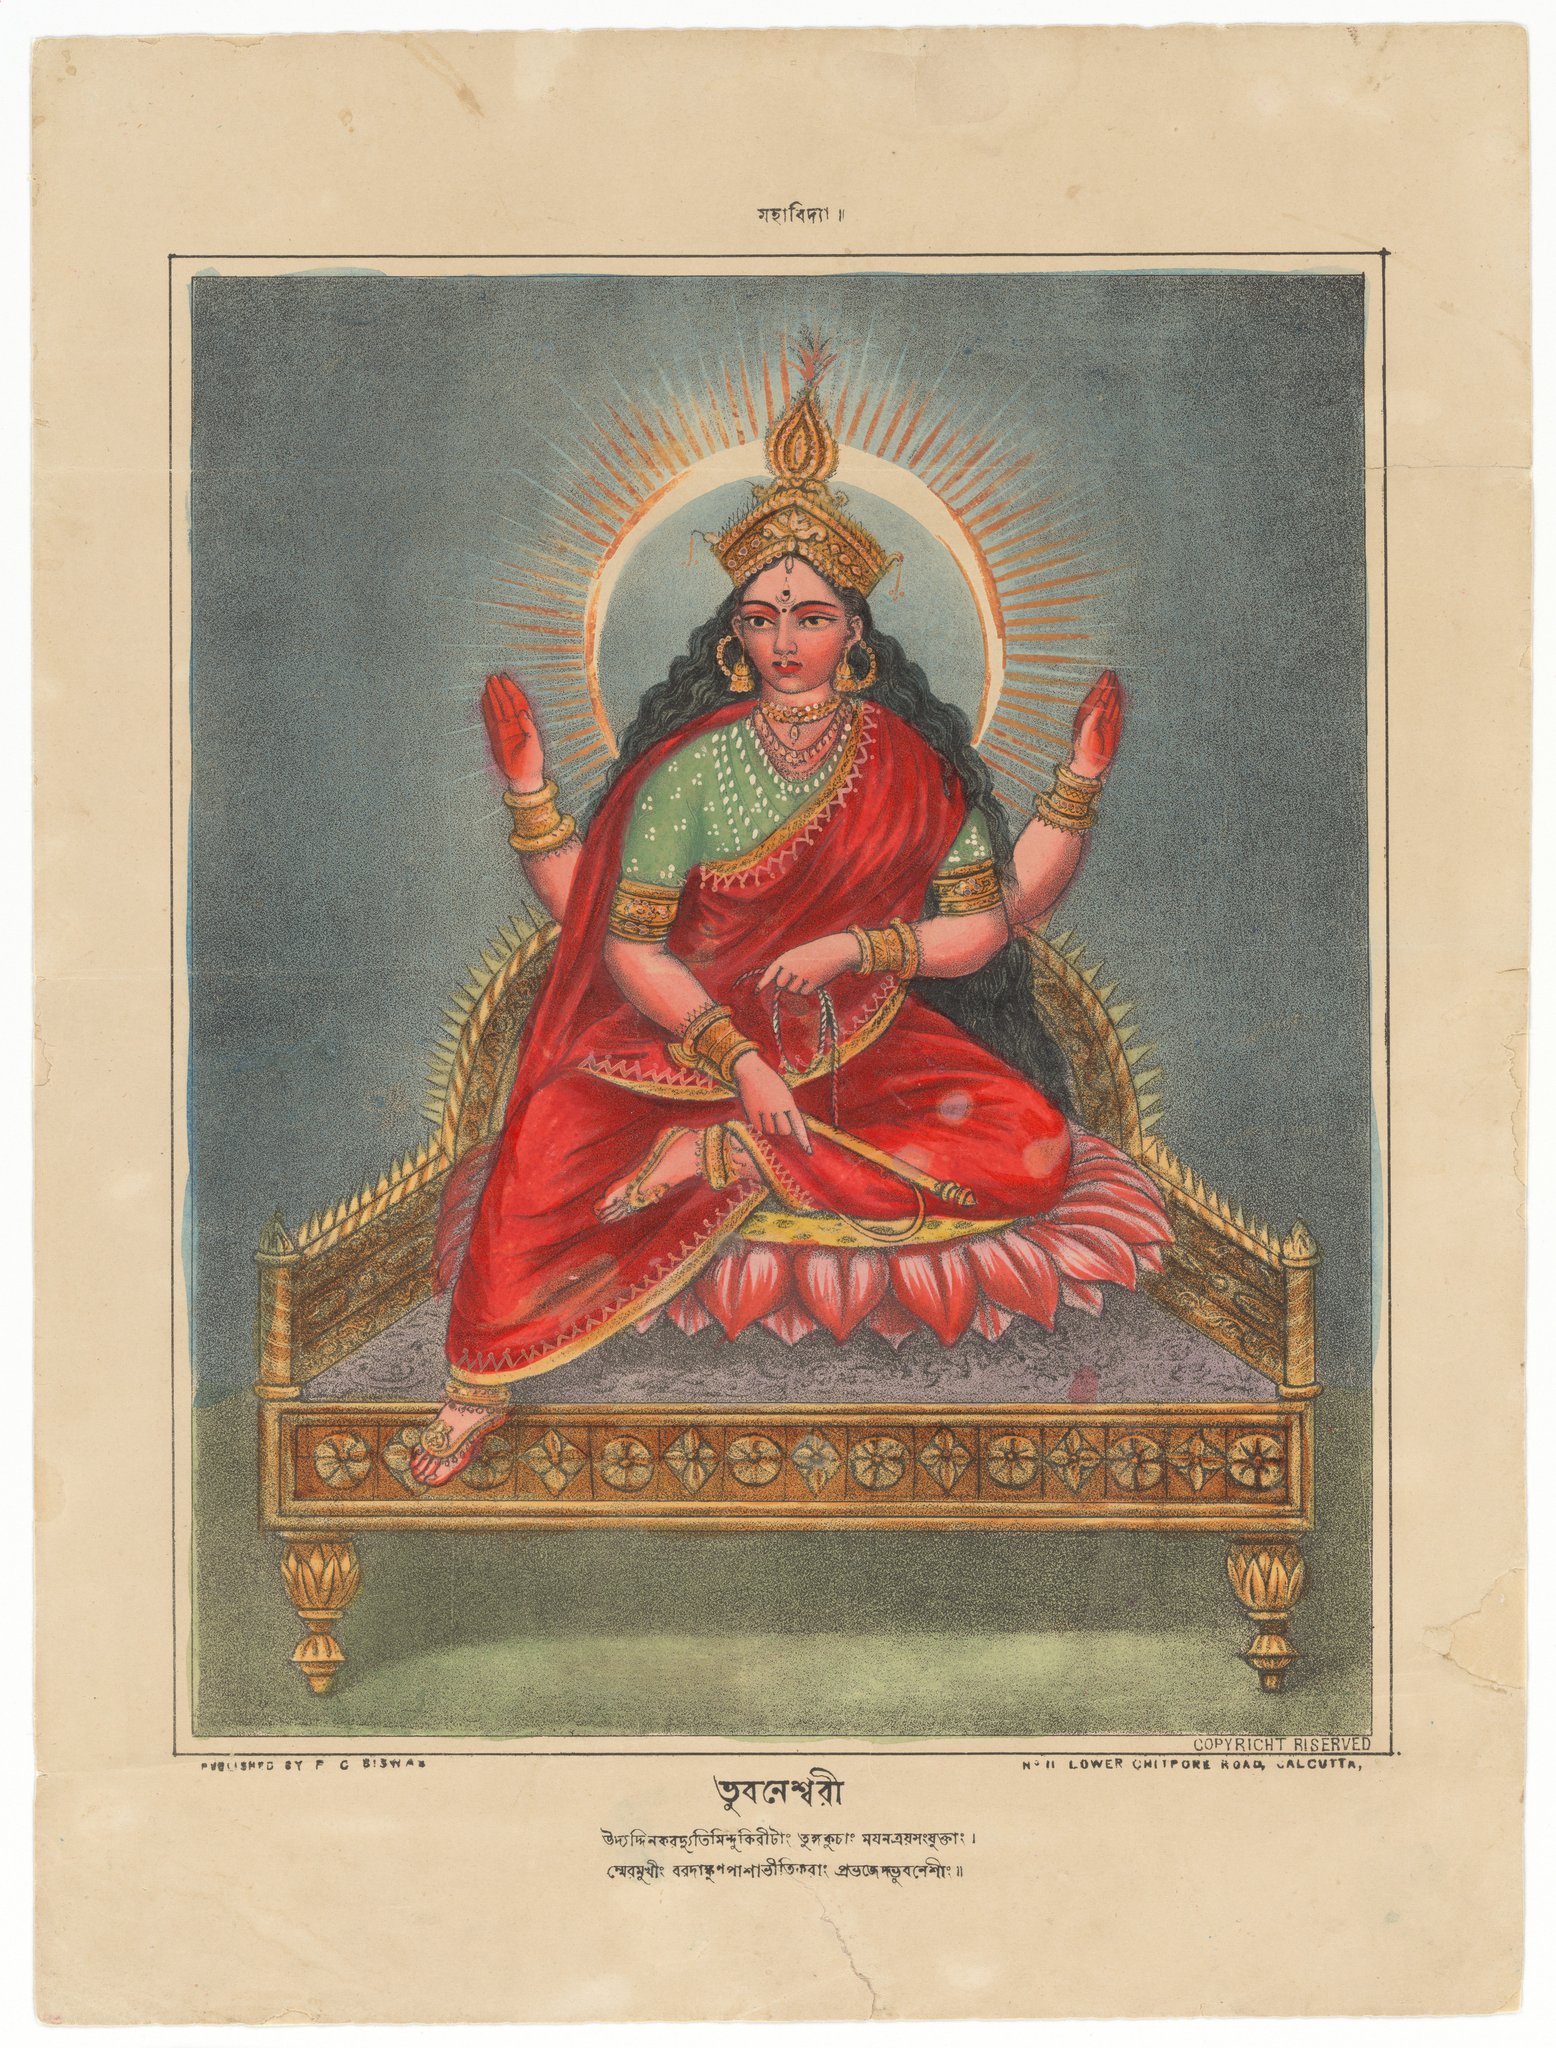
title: Goddess Bhuvaneshvari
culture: west bengali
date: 1880-1885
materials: glaze, watercolor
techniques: hand coloring, lithograph, printing